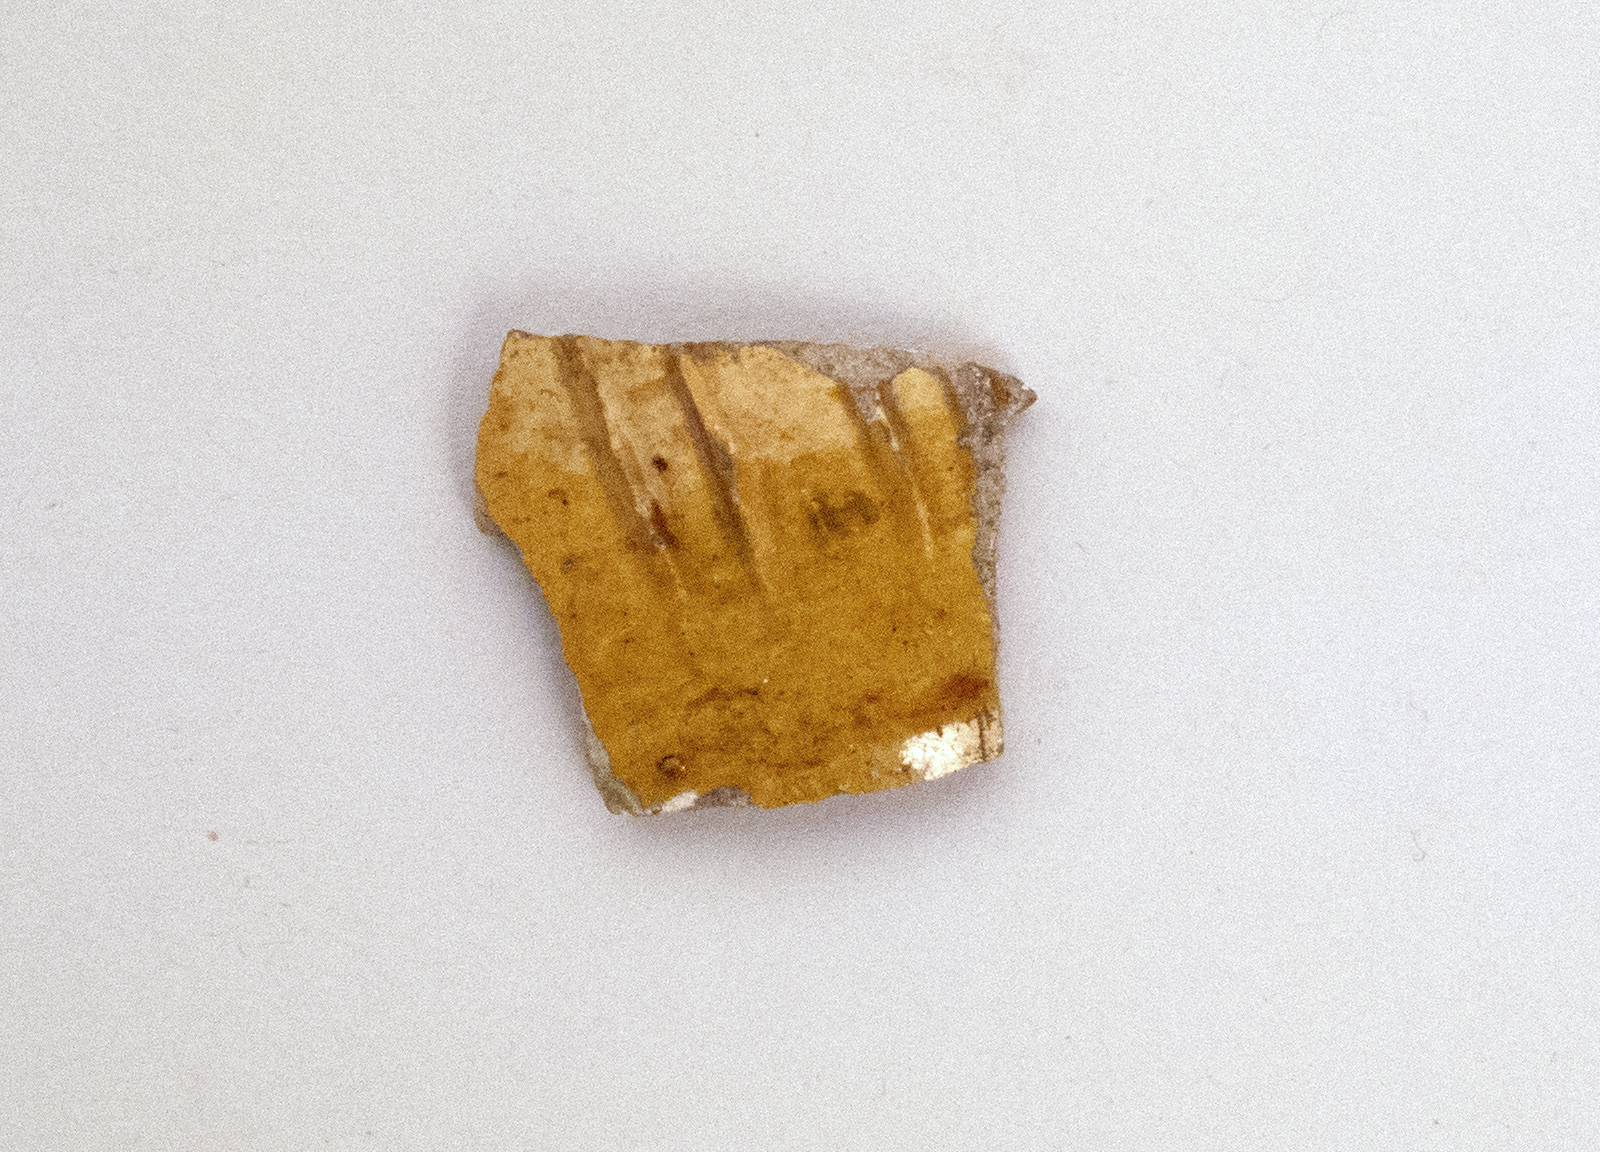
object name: vase fragment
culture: roman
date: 670 BCE-330 CE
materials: terracotta